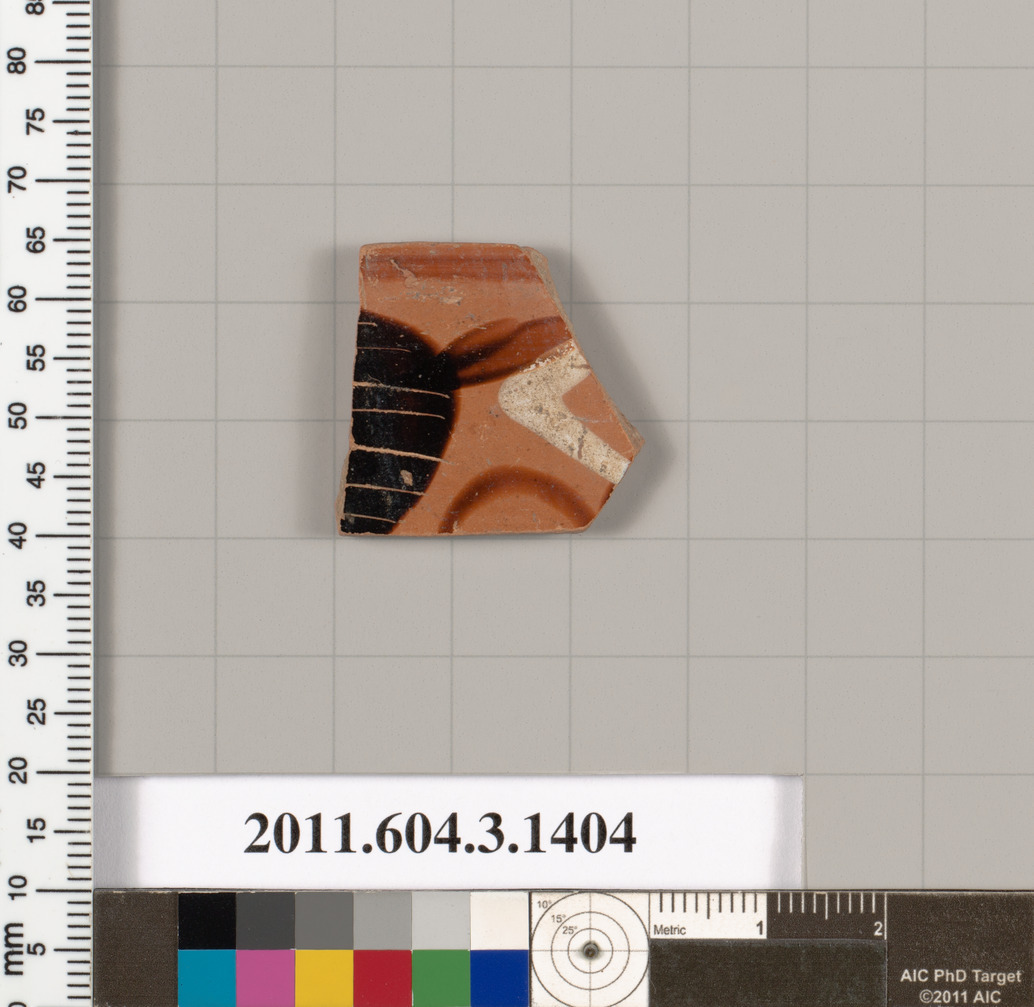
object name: skyphos fragment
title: Terracotta fragment of a skyphos (deep drinking cup)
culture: greek, attic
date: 500-468 BCE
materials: terracotta